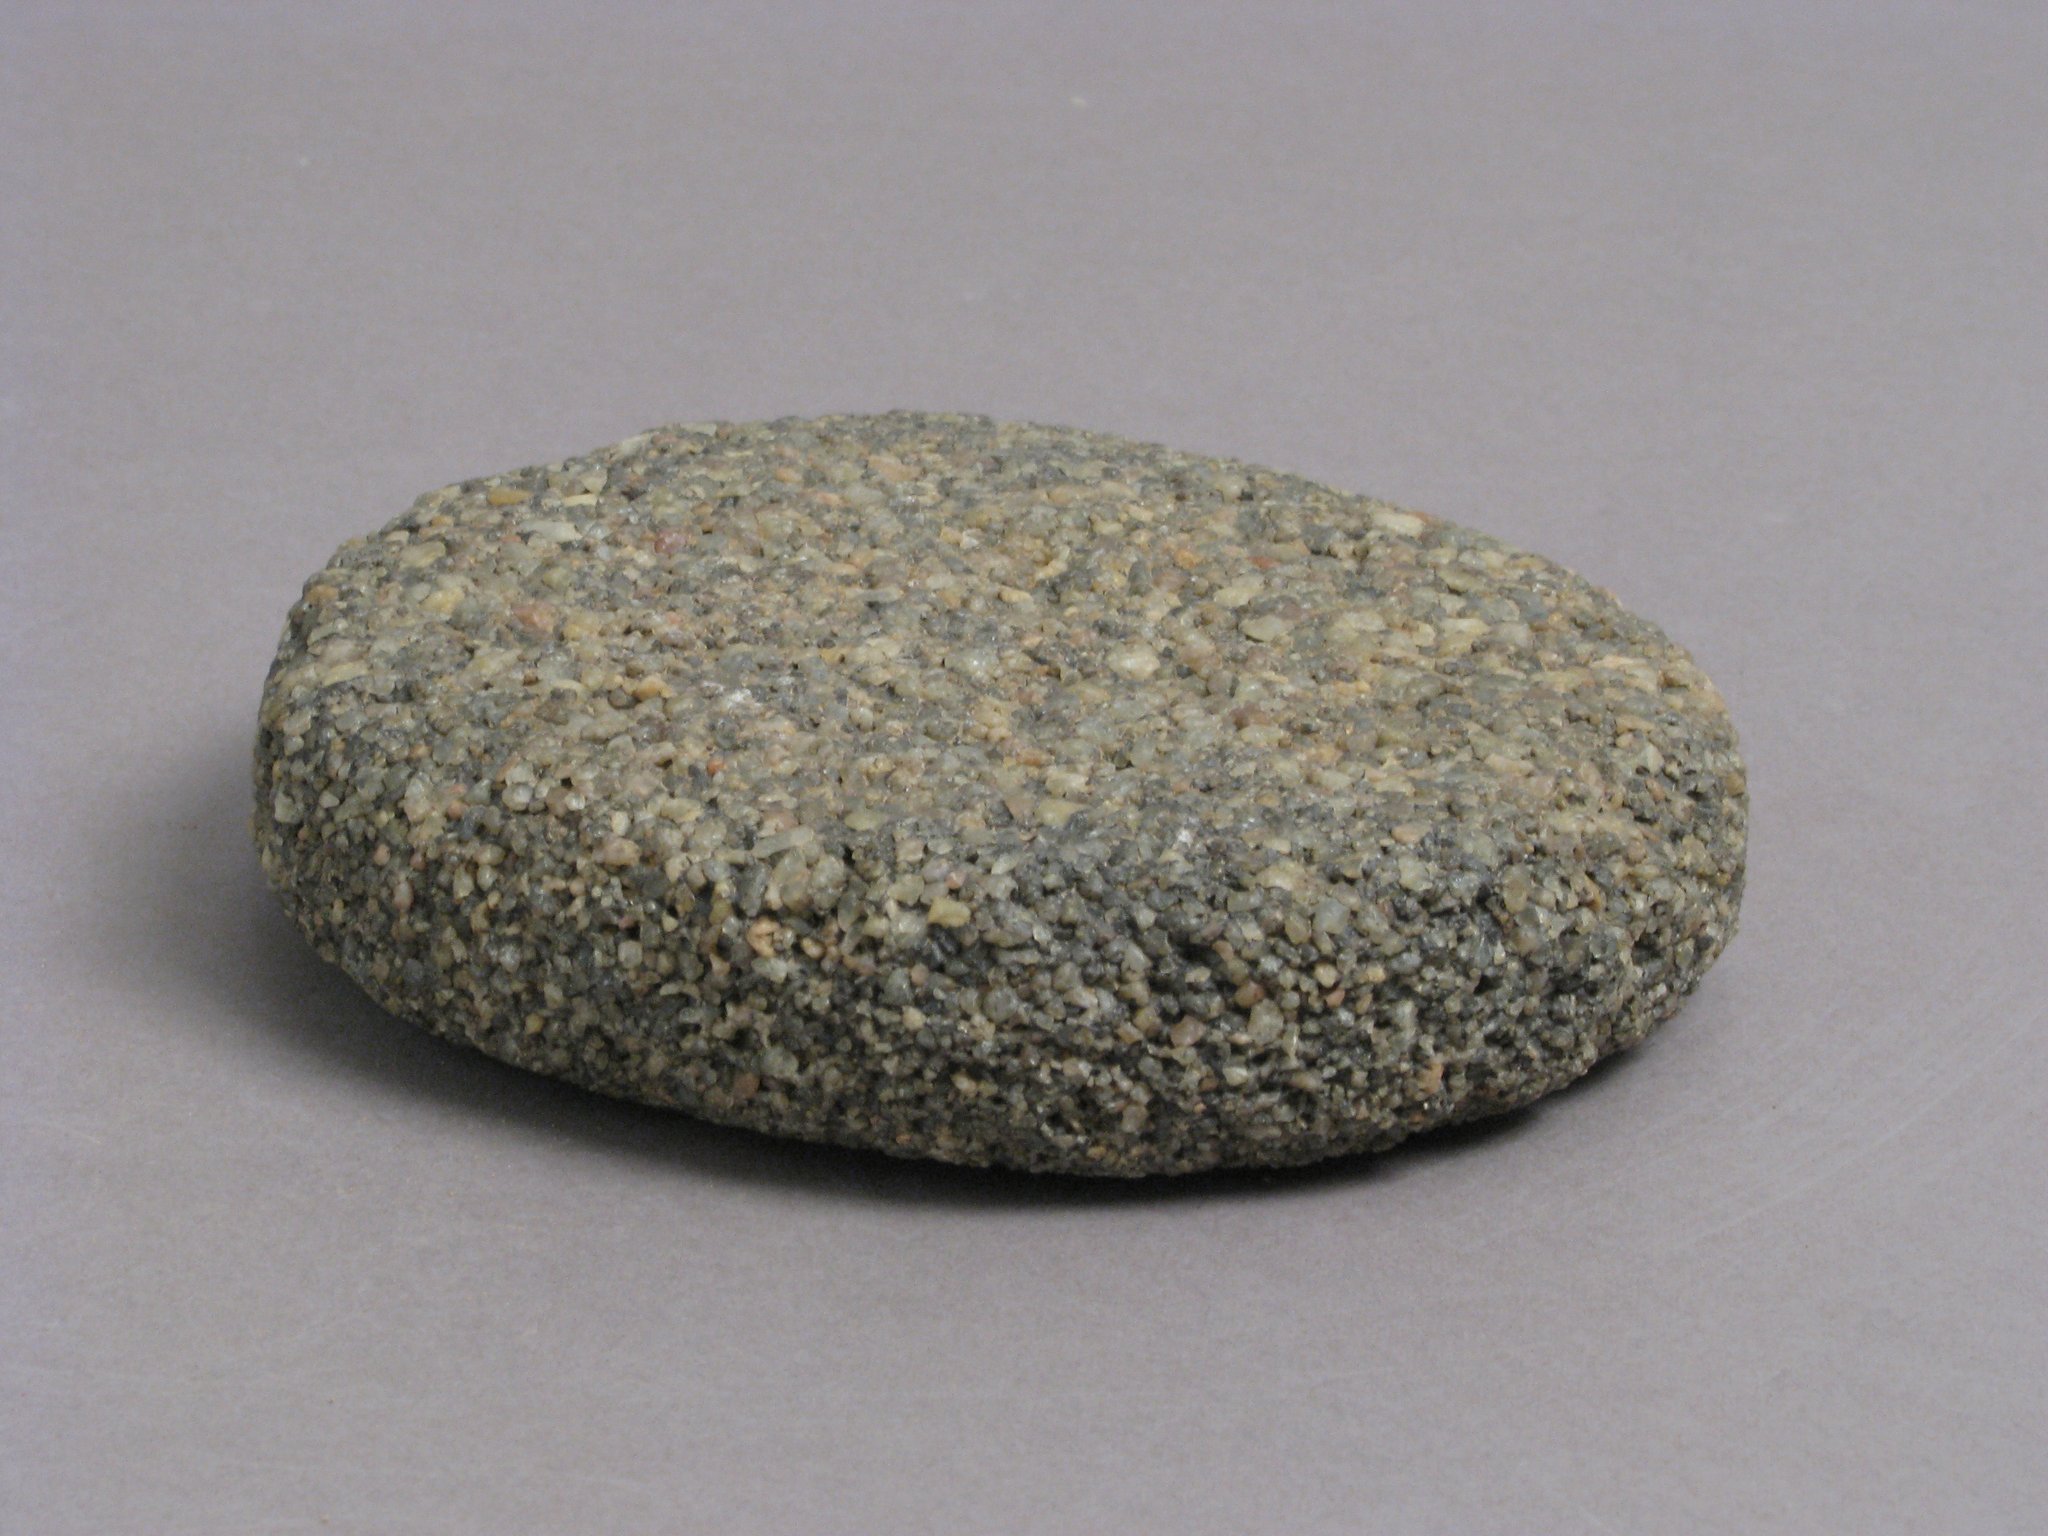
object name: stone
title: Grinding Stone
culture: coptic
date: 301-700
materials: stone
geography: egypt